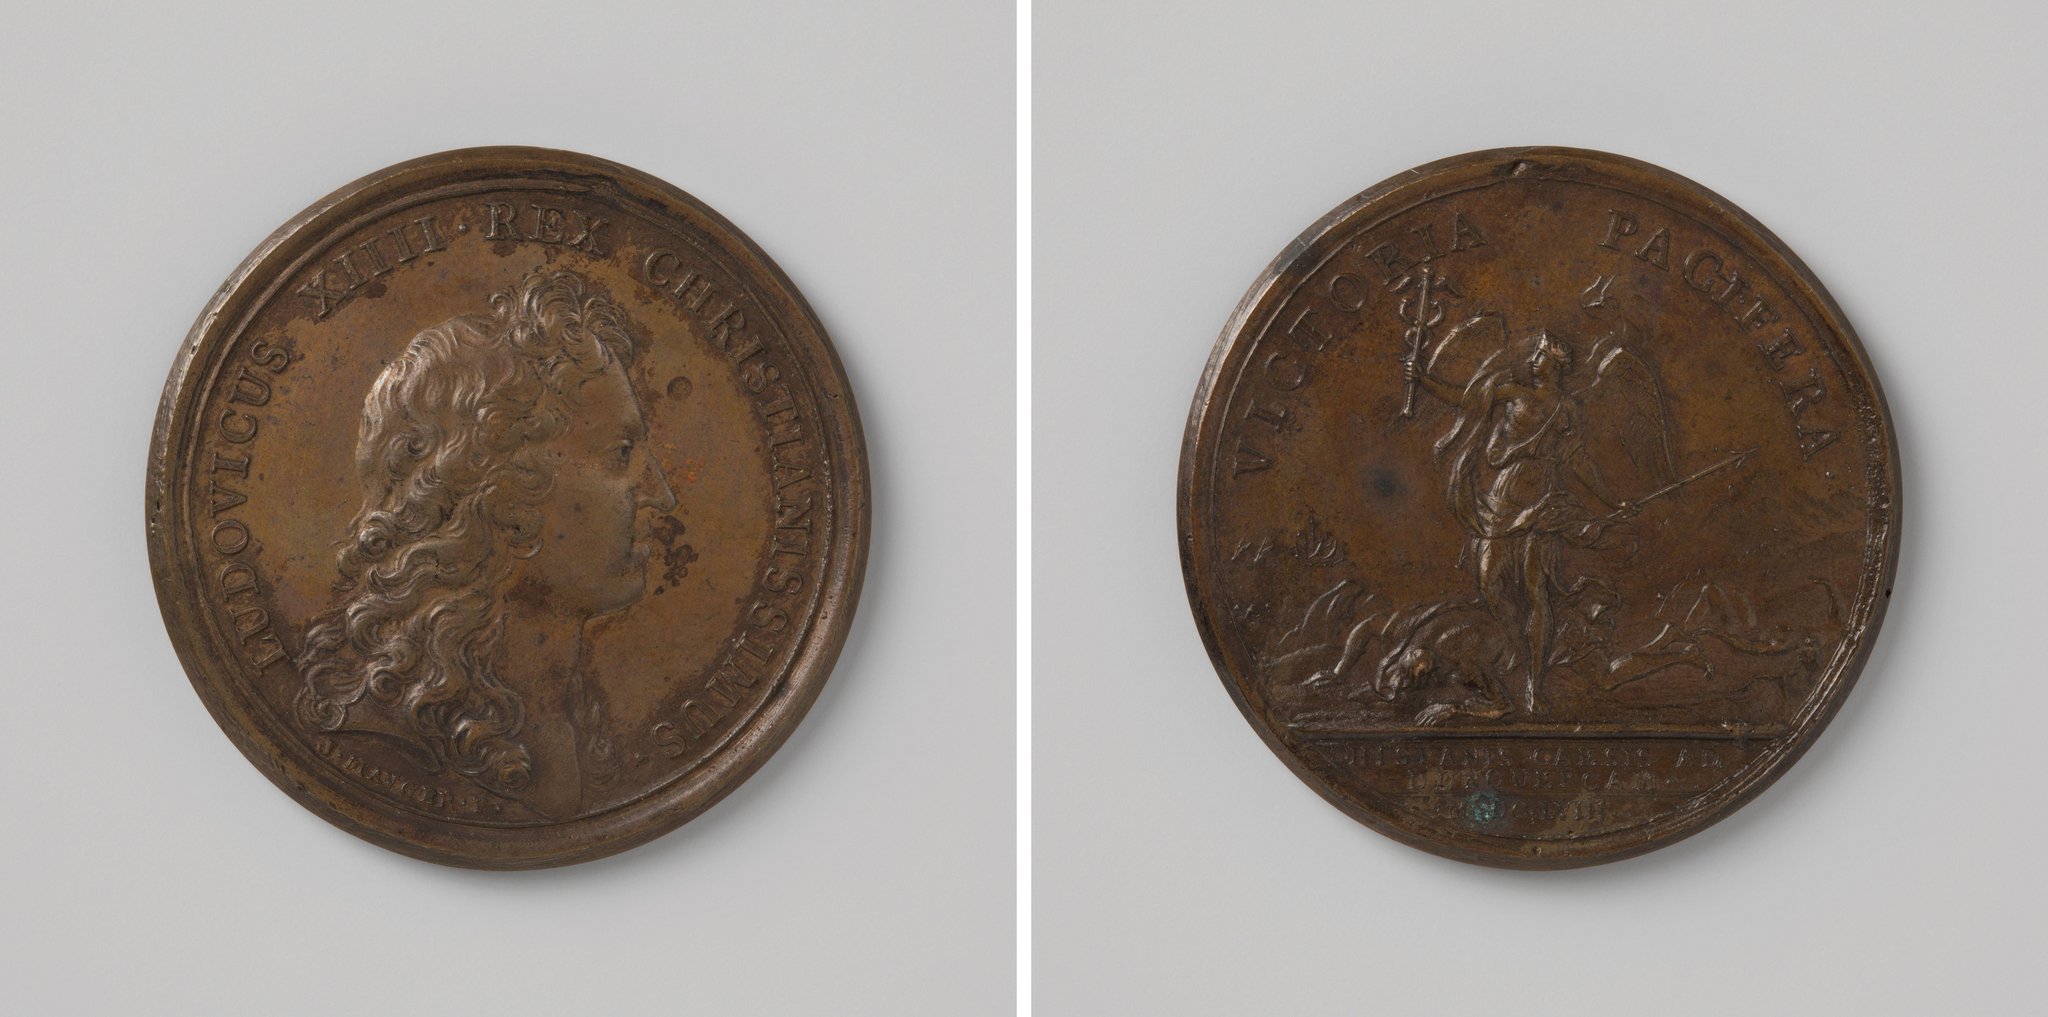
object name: history medal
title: Spanjaarden bij Duinkerken verslagen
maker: jean mauger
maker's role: medailleur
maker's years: 1648-1722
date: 1699-1703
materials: bronze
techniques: striking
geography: paris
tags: lodewijk xiv (koning van frankrijk)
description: Bronzen penning. Voorzijde: borststuk jongeman (Lodewijk XIV) binnen omschrift. Keerzijde: gevleugelde Overwinning met speer en Mercuriusstaf vertrapt verslagen Spanjaarden binnen omschrift; afsnede: opschrift